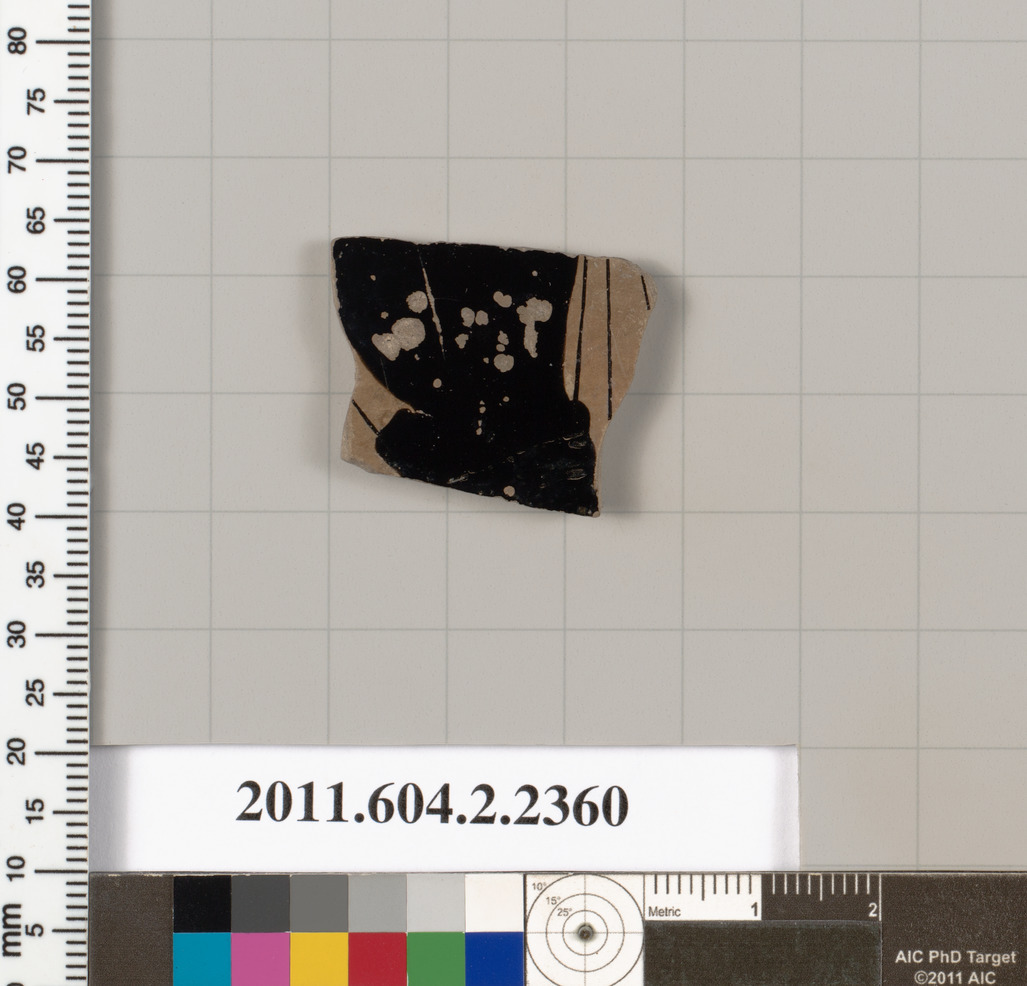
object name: pot fragment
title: Terracotta fragment of a pot; unglazed on the inside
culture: greek, attic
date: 475-451 BCE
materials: terracotta